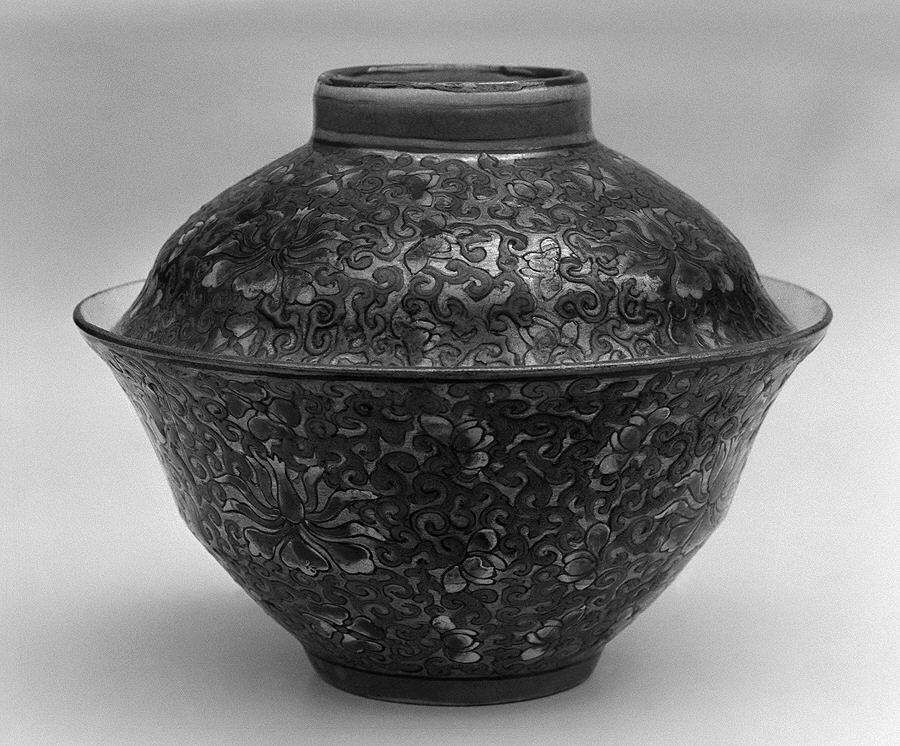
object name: bowl with cover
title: Covered bowl with floral patterns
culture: chinese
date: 1834-1866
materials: enamel, porcelain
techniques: overglaze, painting, polychrome